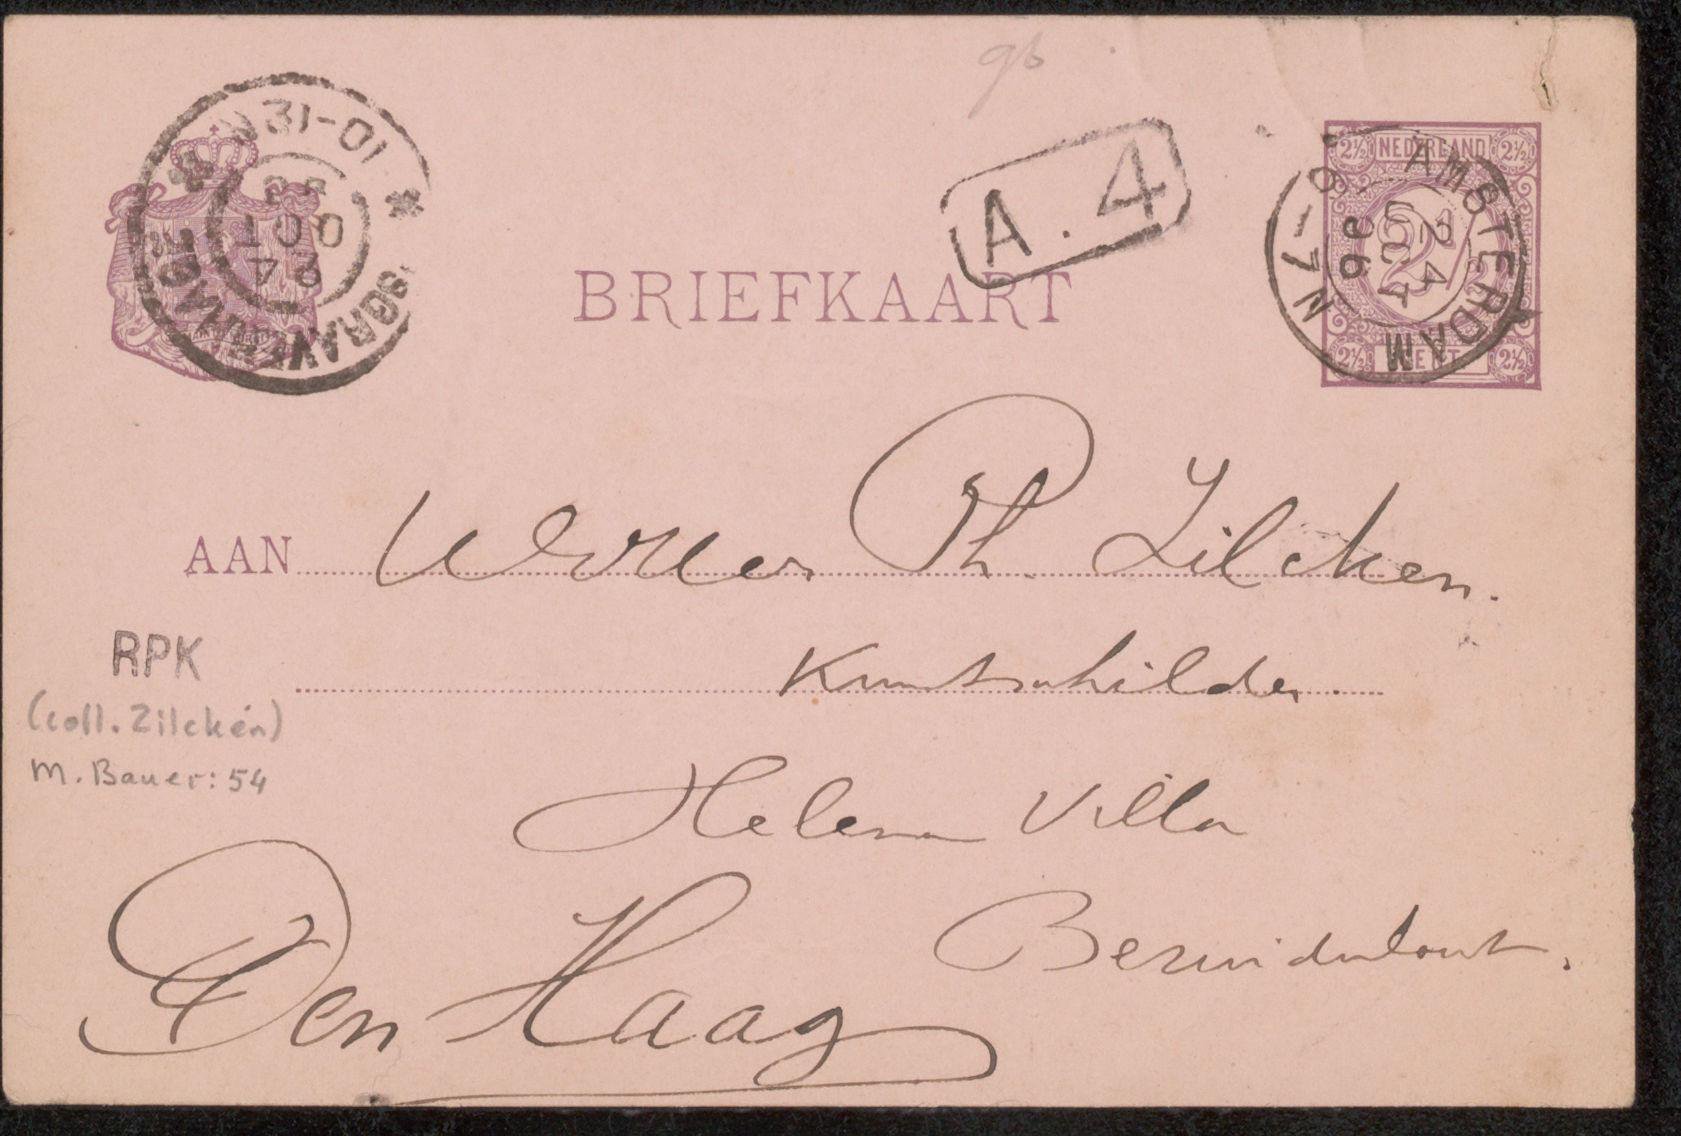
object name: postcard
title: Briefkaart aan Philip Zilcken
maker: marius bauer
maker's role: draughtsman, print maker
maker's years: 1867-1932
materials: cardboard, ink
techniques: pen, writing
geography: amsterdam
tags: painter, philip zilcken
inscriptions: collector's mark: ‘RPK’